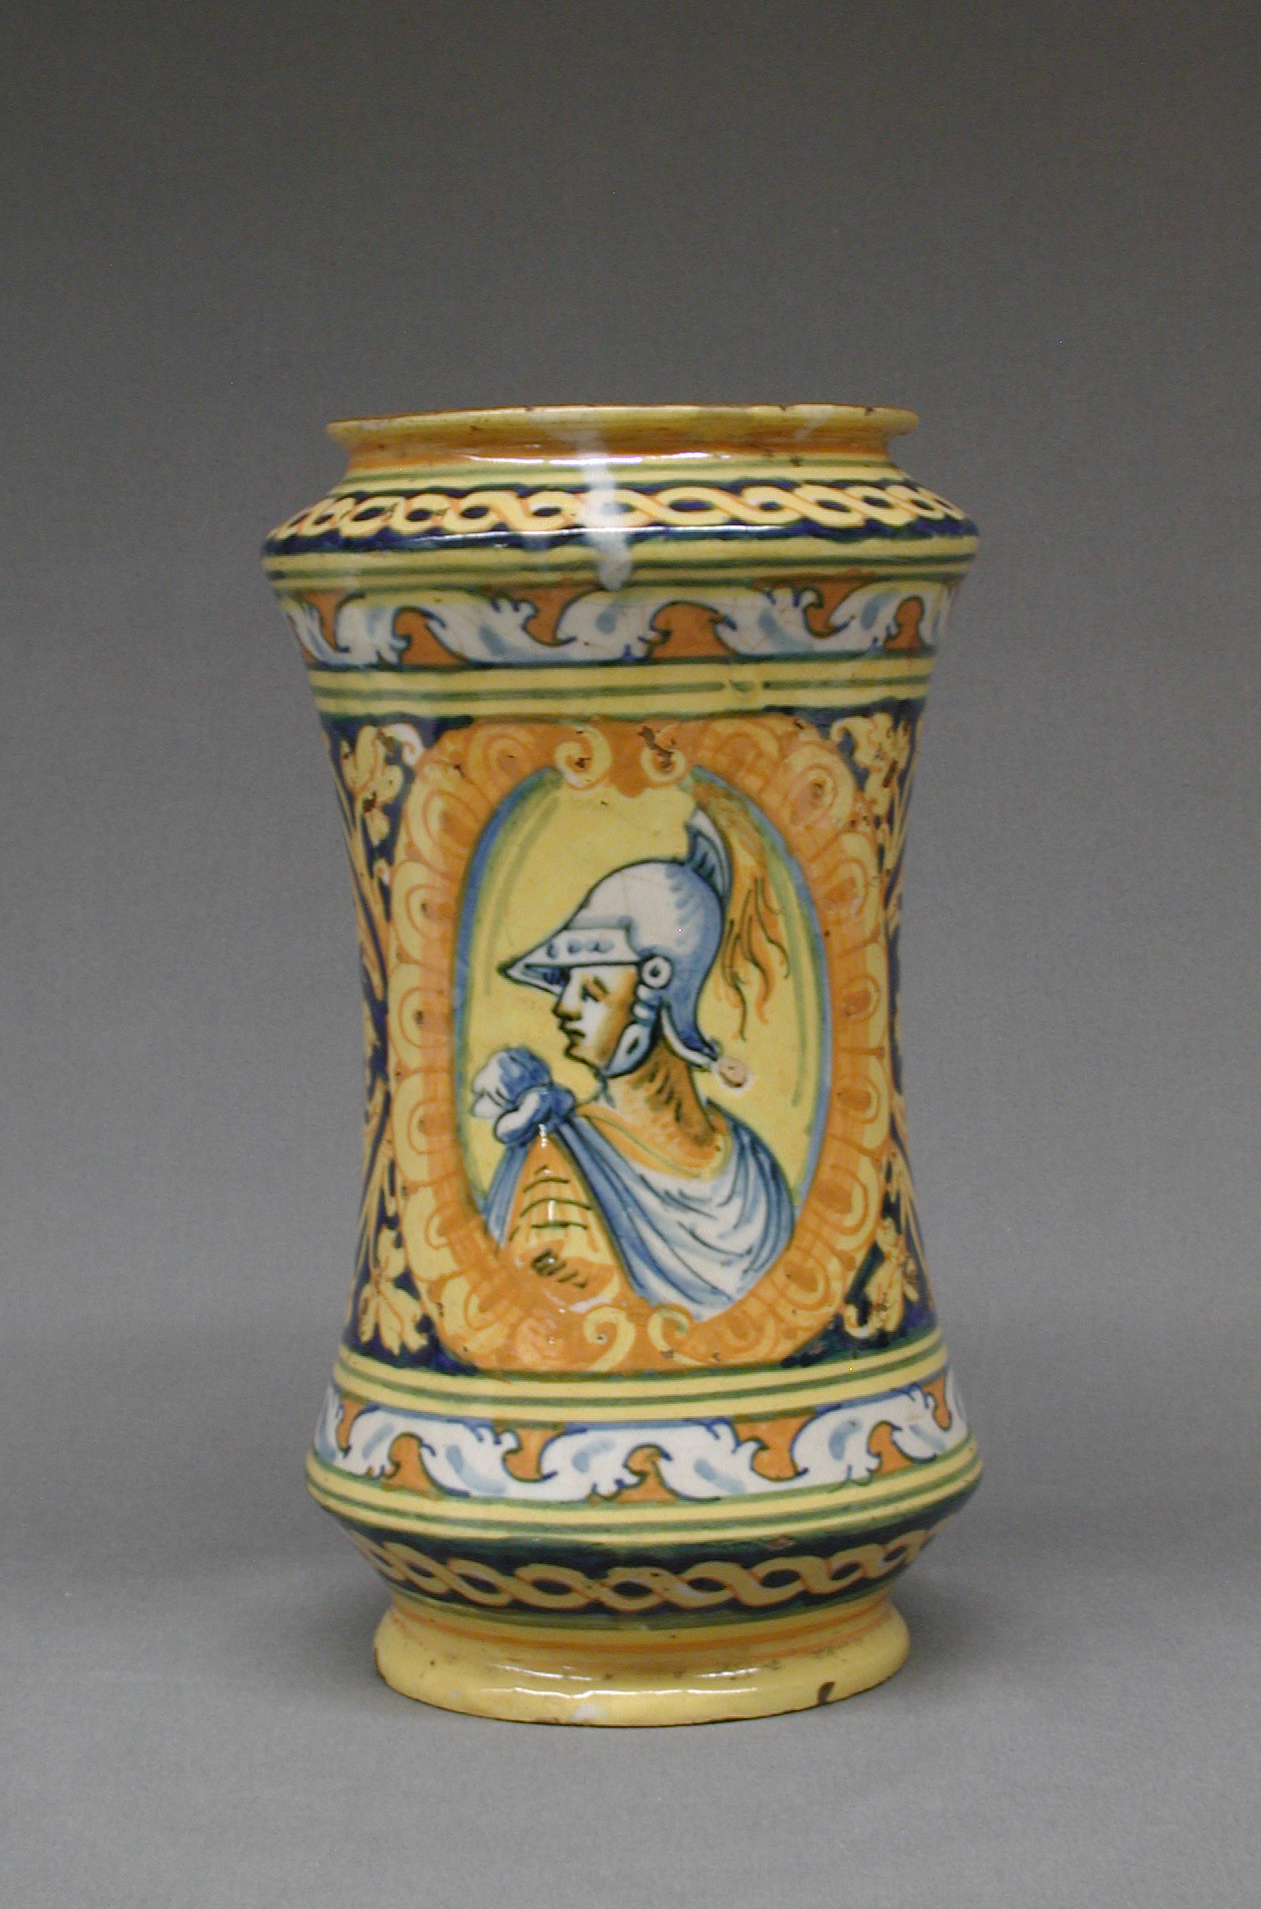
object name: albarello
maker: vincenzo di marco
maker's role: maker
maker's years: 1525-1625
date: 1551-1600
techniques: maiolica, glazing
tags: men,profiles